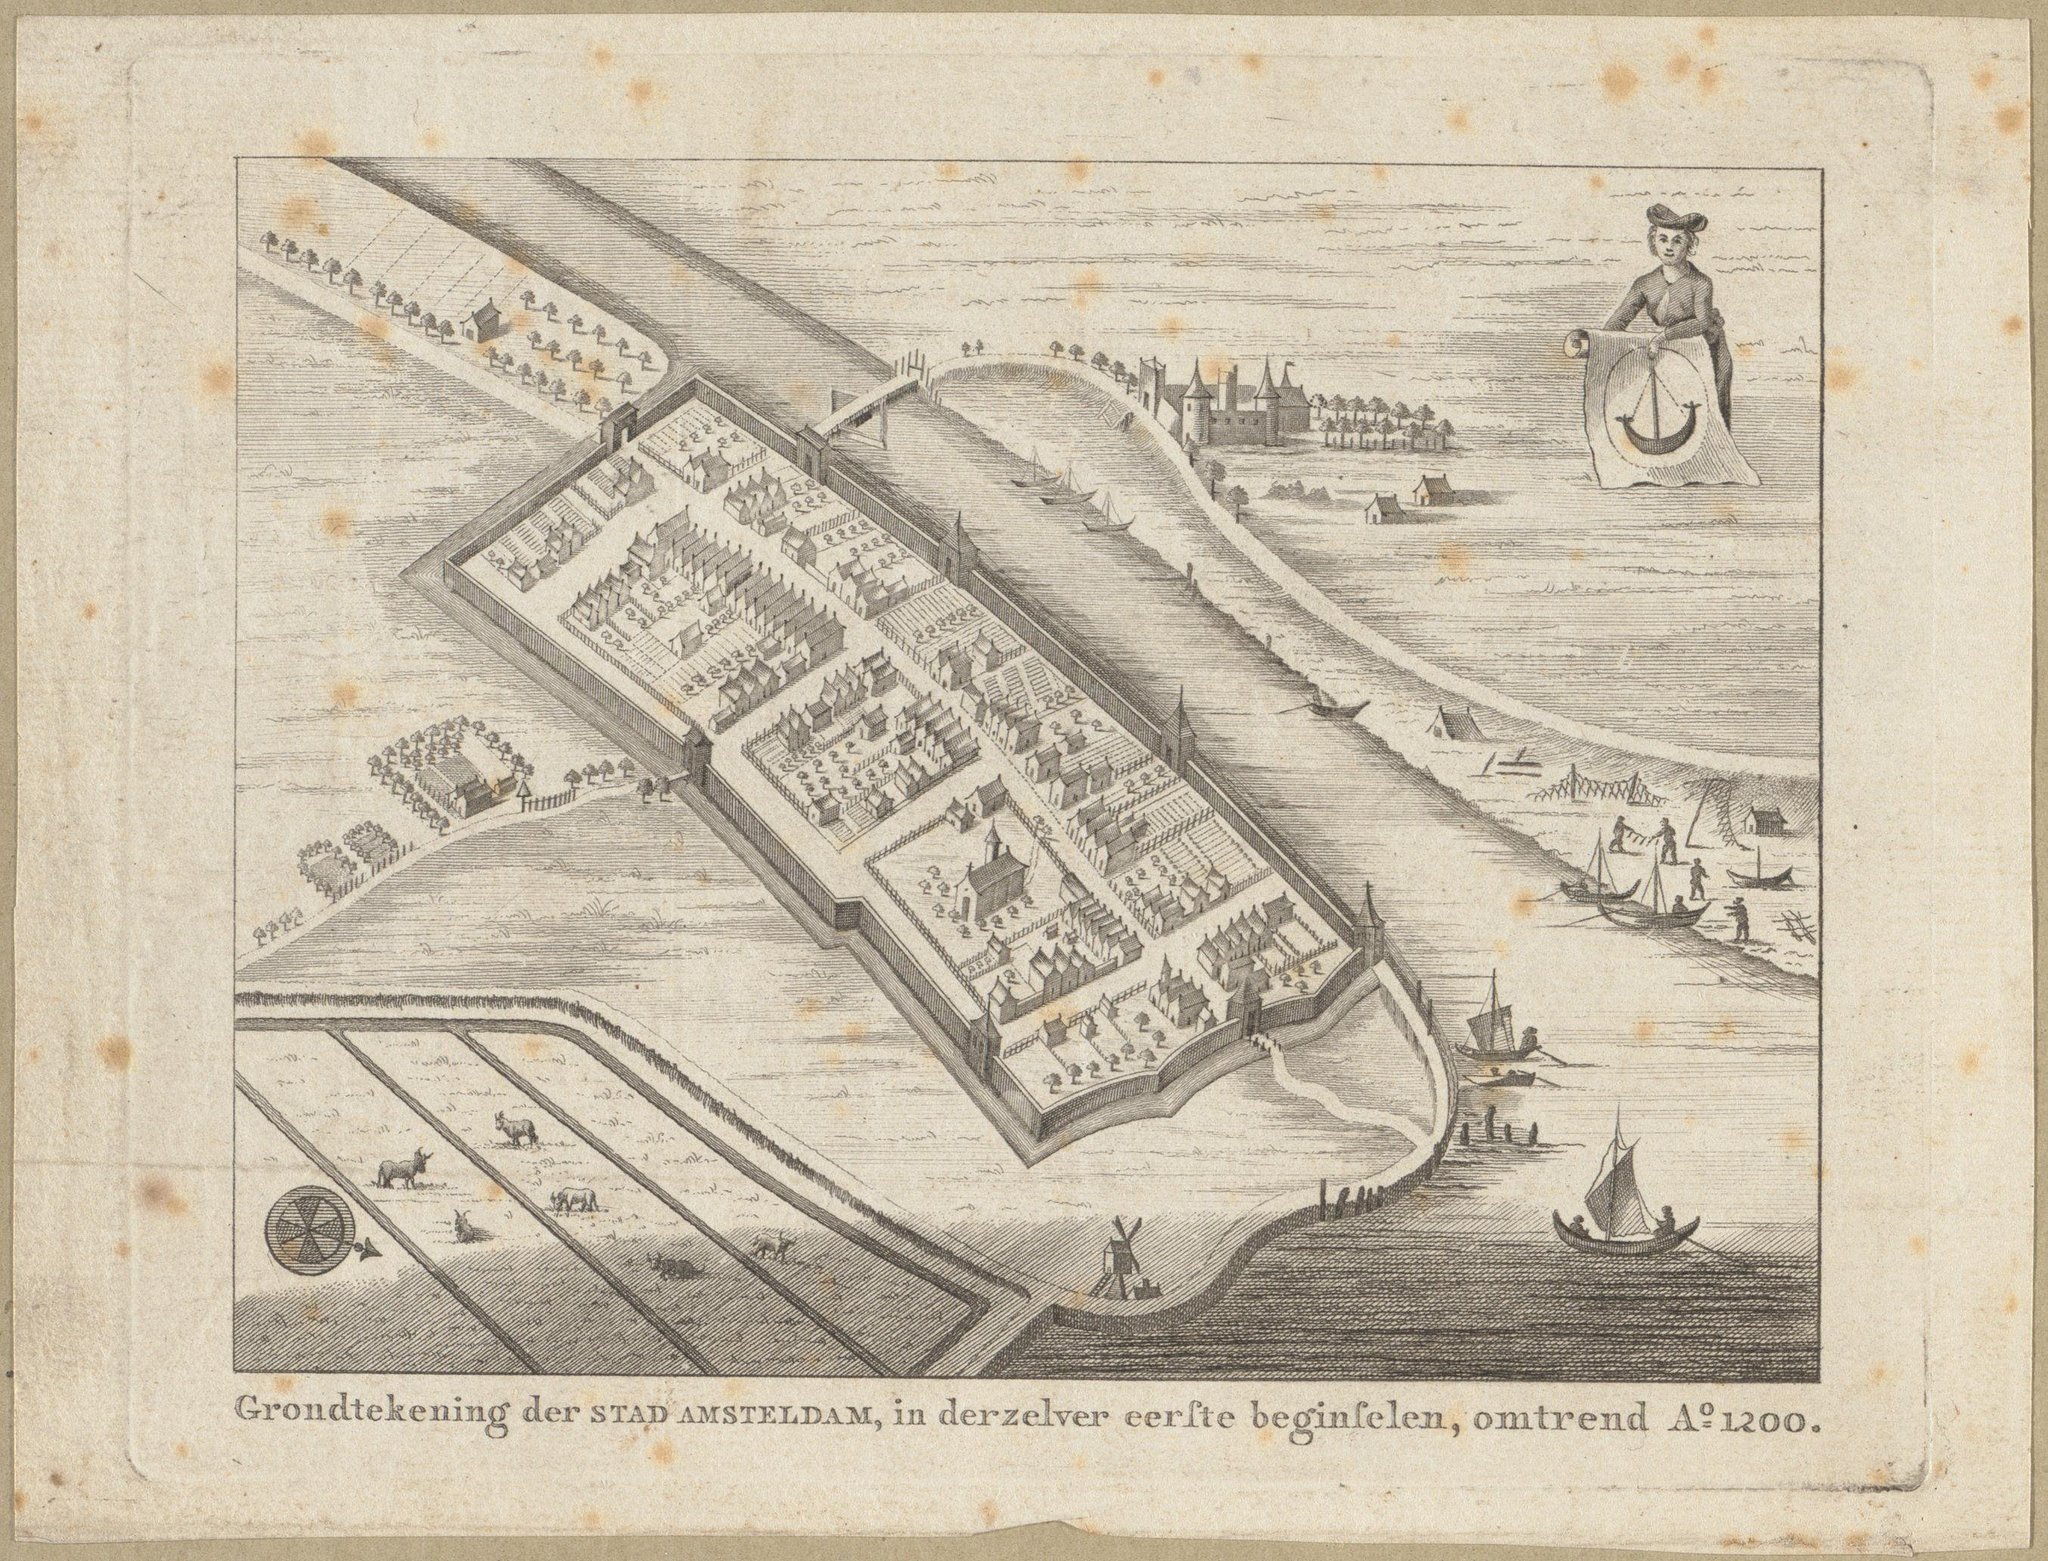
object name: map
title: Grondtekening der stad Amsteldam, in derzelver eerste beginselen, omtrend Ao. 1200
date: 1788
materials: paper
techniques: engraving, etching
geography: amsterdam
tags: maps of cities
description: Prent mogelijk uit: Fokke, Jan. Amsteldam en zyne geschiedenissen, in’t kort. Amsterdam: Johannes Allart, 1788, dl. 1.